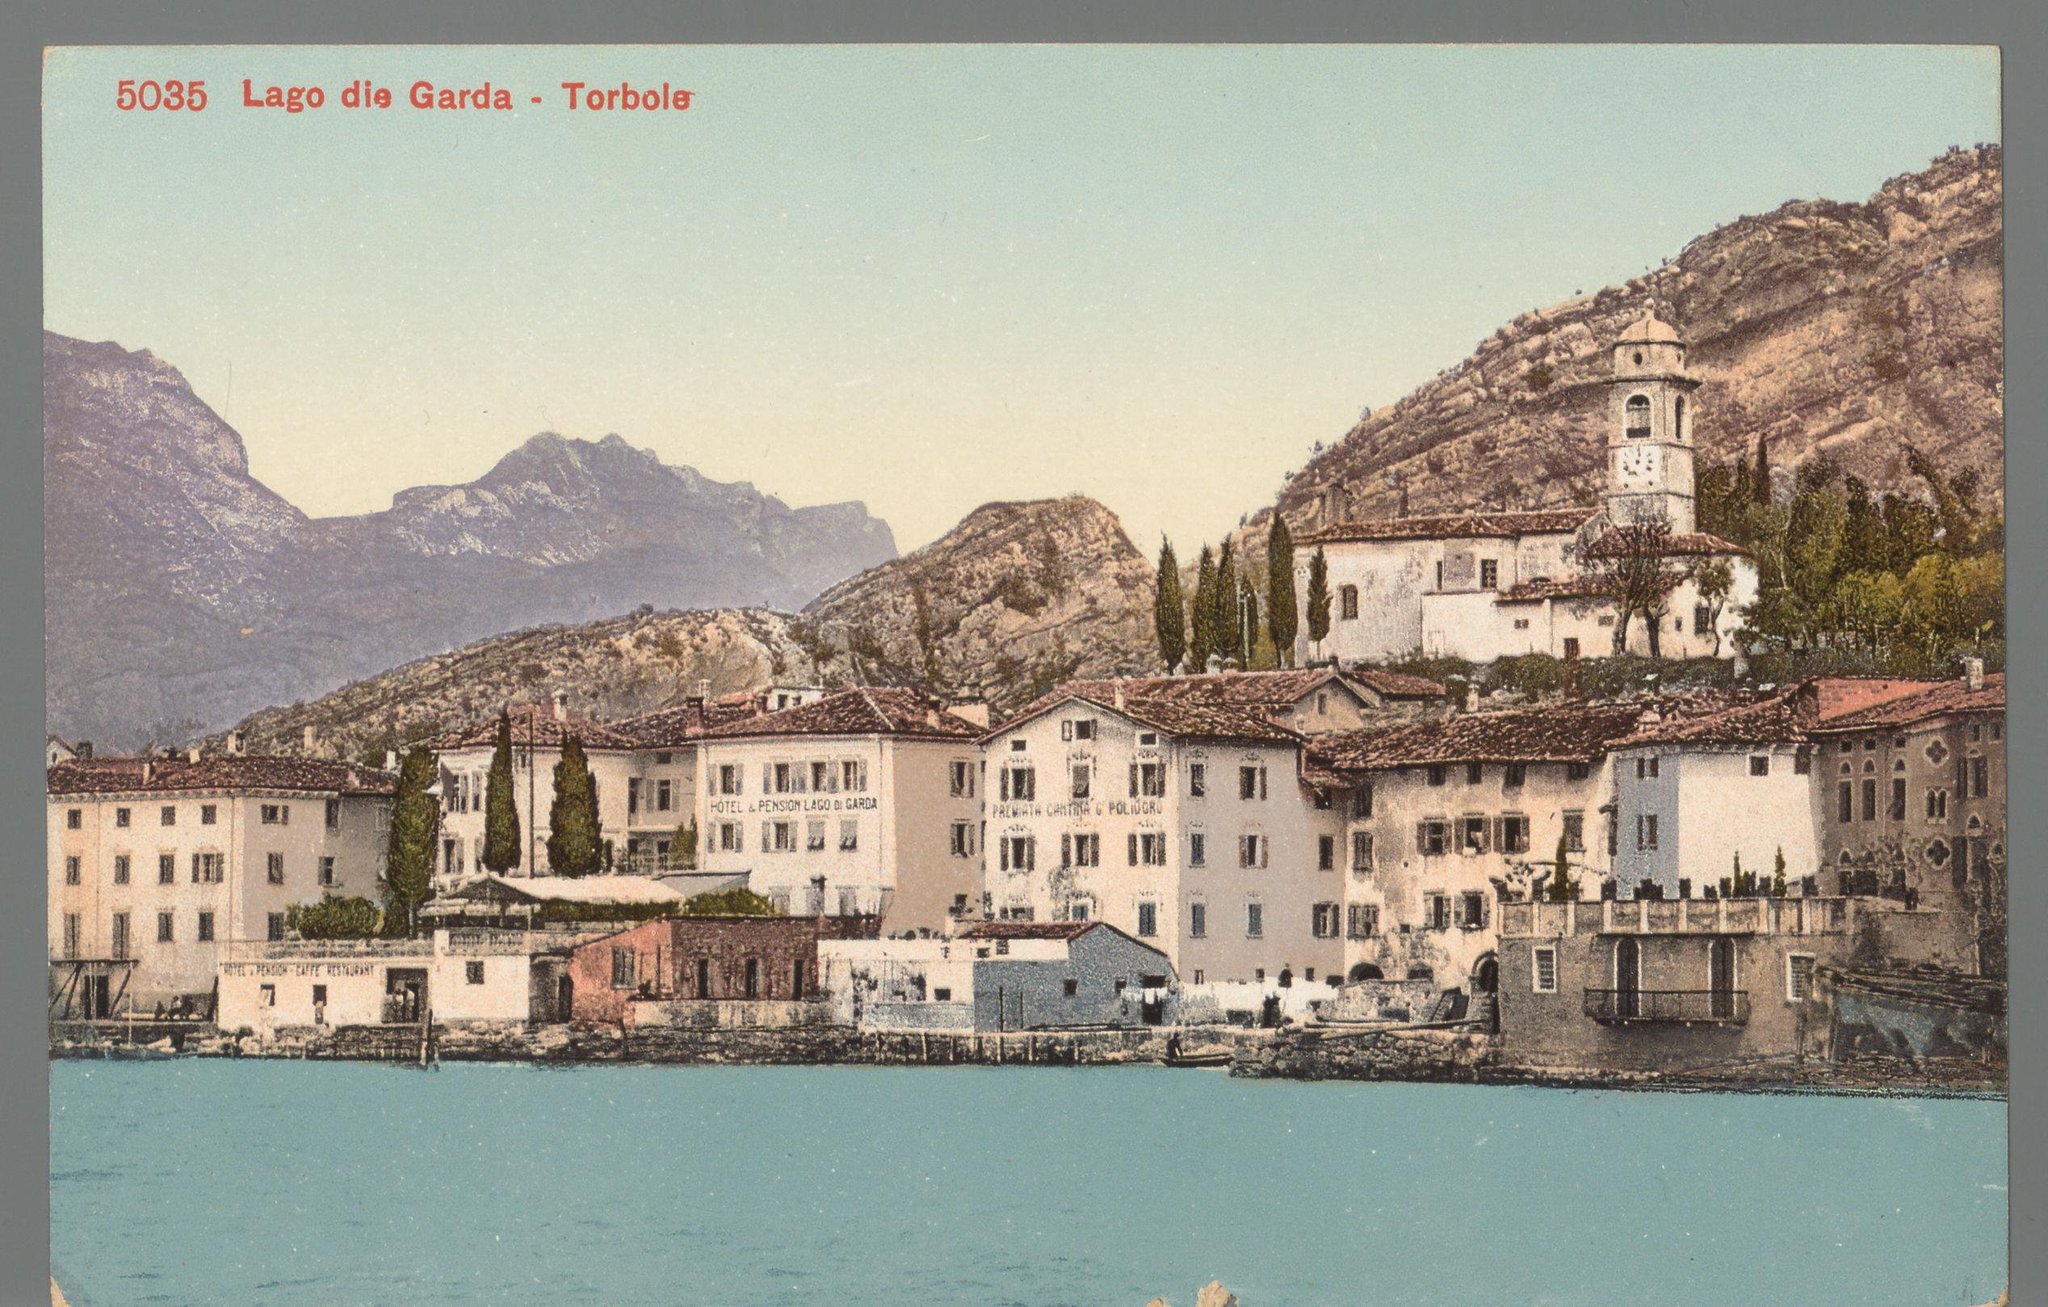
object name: ansichtkaart, prentbriefkaart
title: Lago di Garda. Torbole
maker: Anonymous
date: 1905-1930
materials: cardboard, photographic process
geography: torbole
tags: prospect of village, silhouette of village, lake, mountains